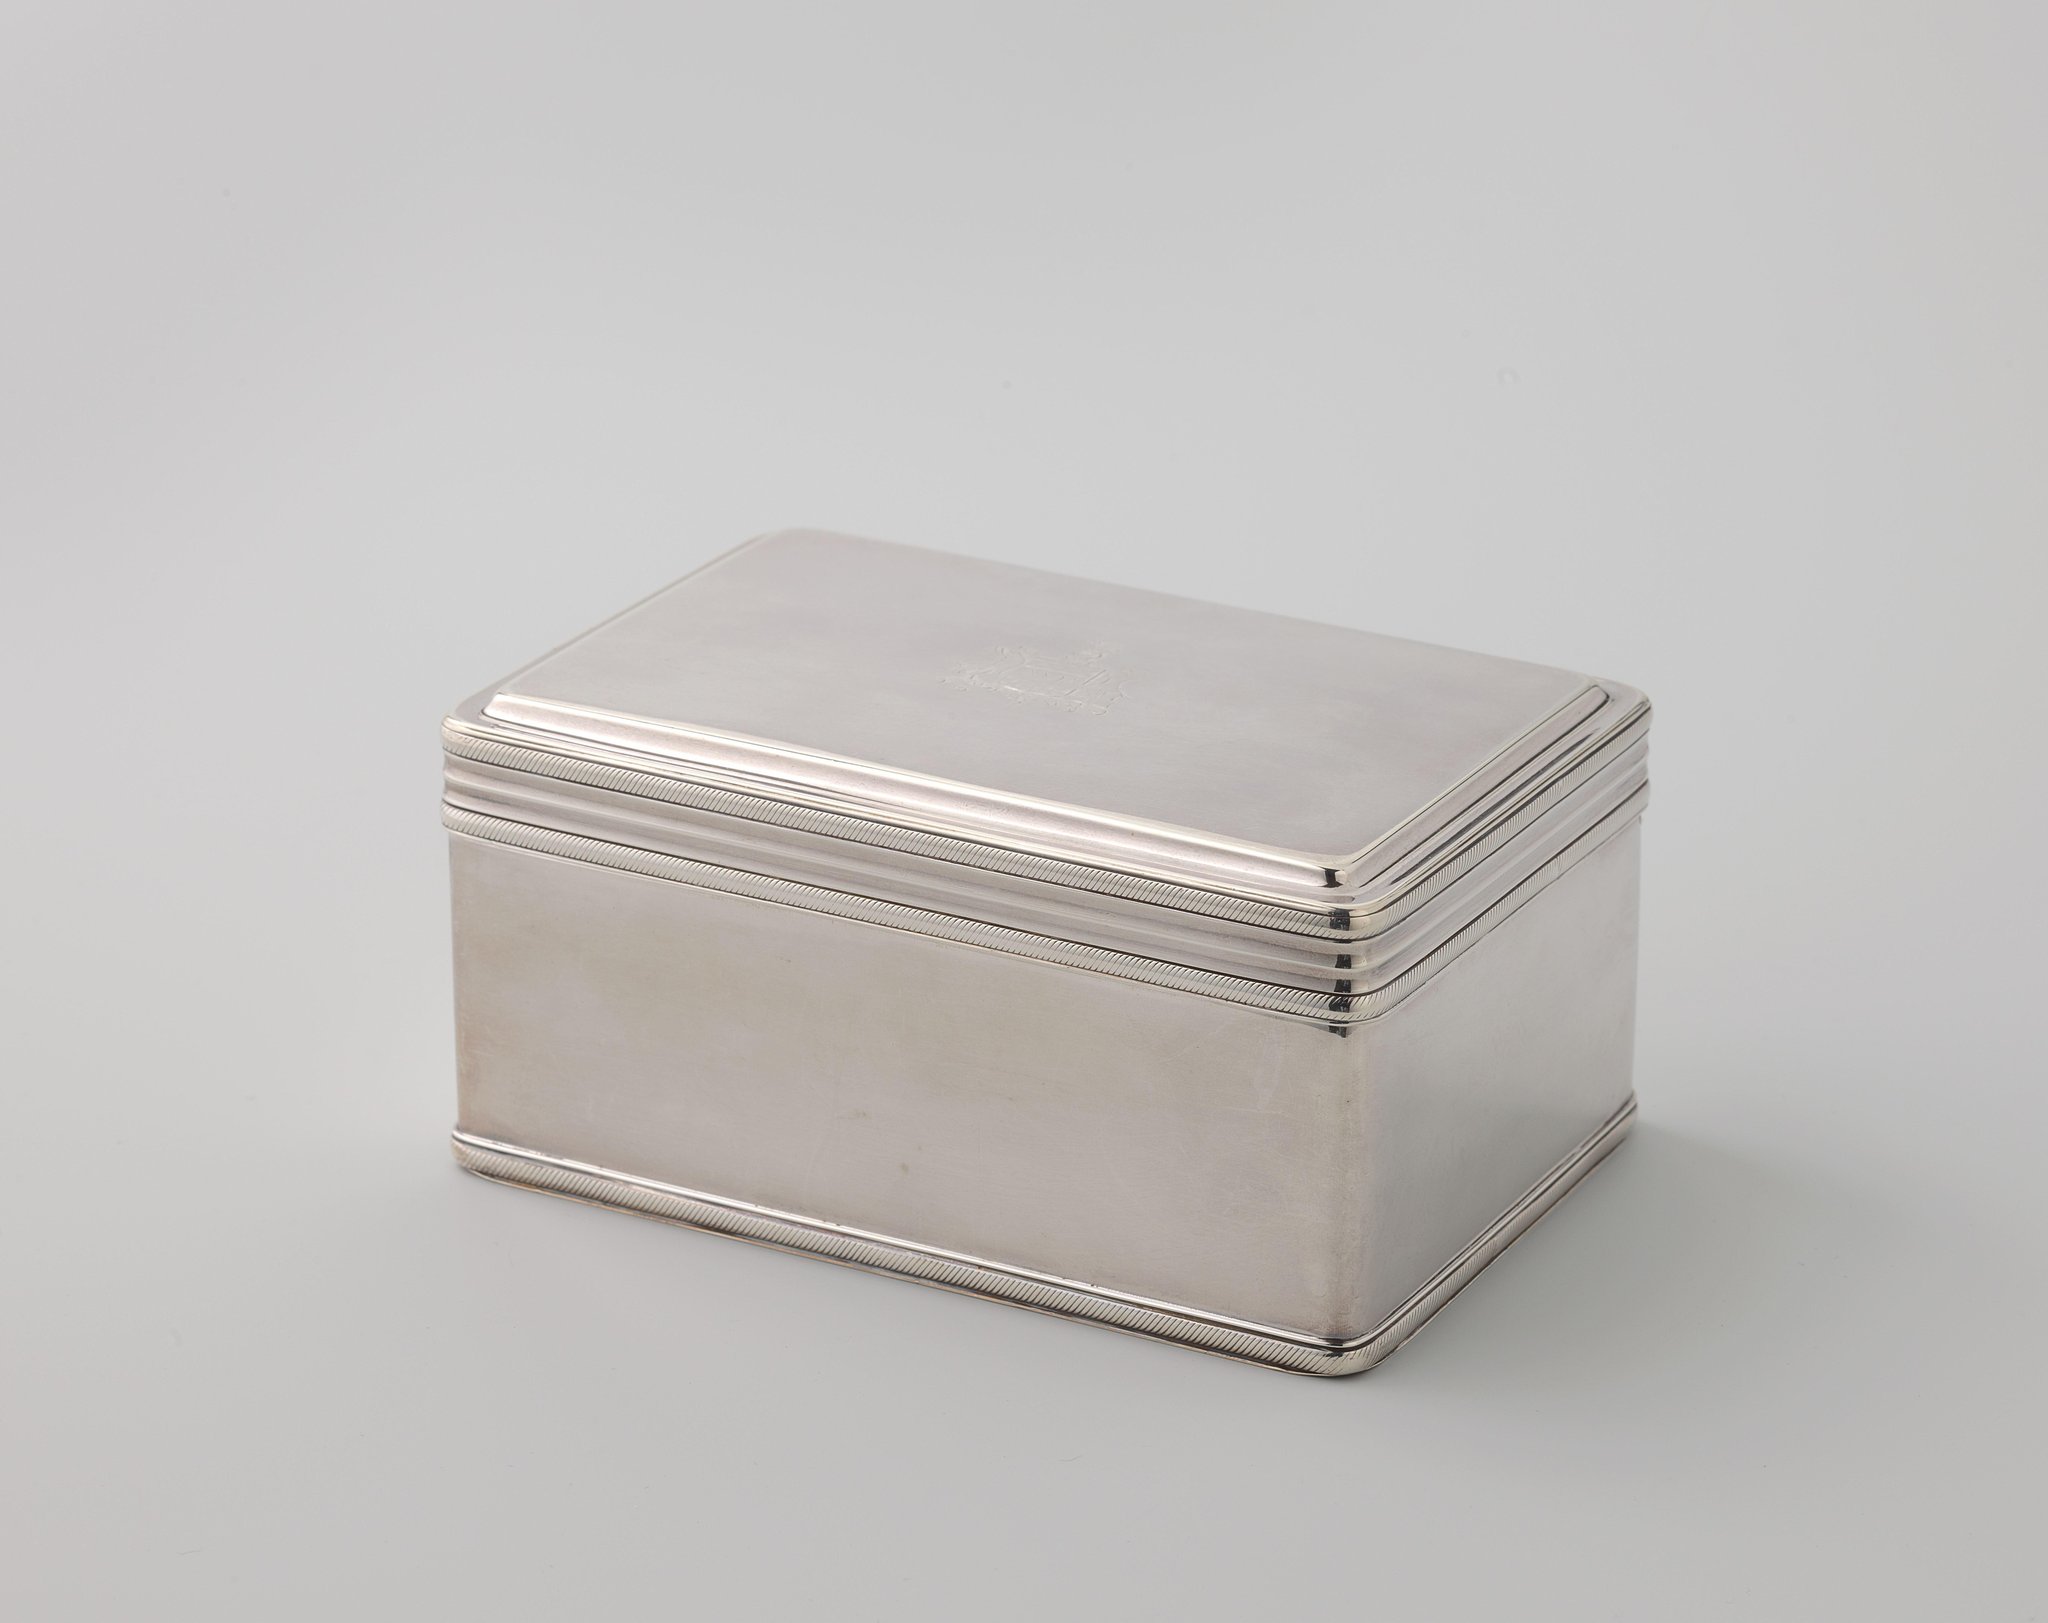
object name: biscuit box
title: Trommel, rechthoekig, met het familiewapen Clifford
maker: weduwe j.h. stellingwerff en van grasstek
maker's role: silversmith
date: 1838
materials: silver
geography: amsterdam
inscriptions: alloy mark, date letter: ‘D’, maker's mark, assay office mark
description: De rechthoekige (F) en de ronde trommel (G) hebben beide een lichtgewelfd scharnierend deksel. Ze hebben een rechte wand en zijn langs de onderzijde en langs de onder- en bovenrand van de geprofileerde dekselwand versierd met kabelranden. Op de deksels is het wapen Clifford met het helmteken en schildhouders gegraveerd.